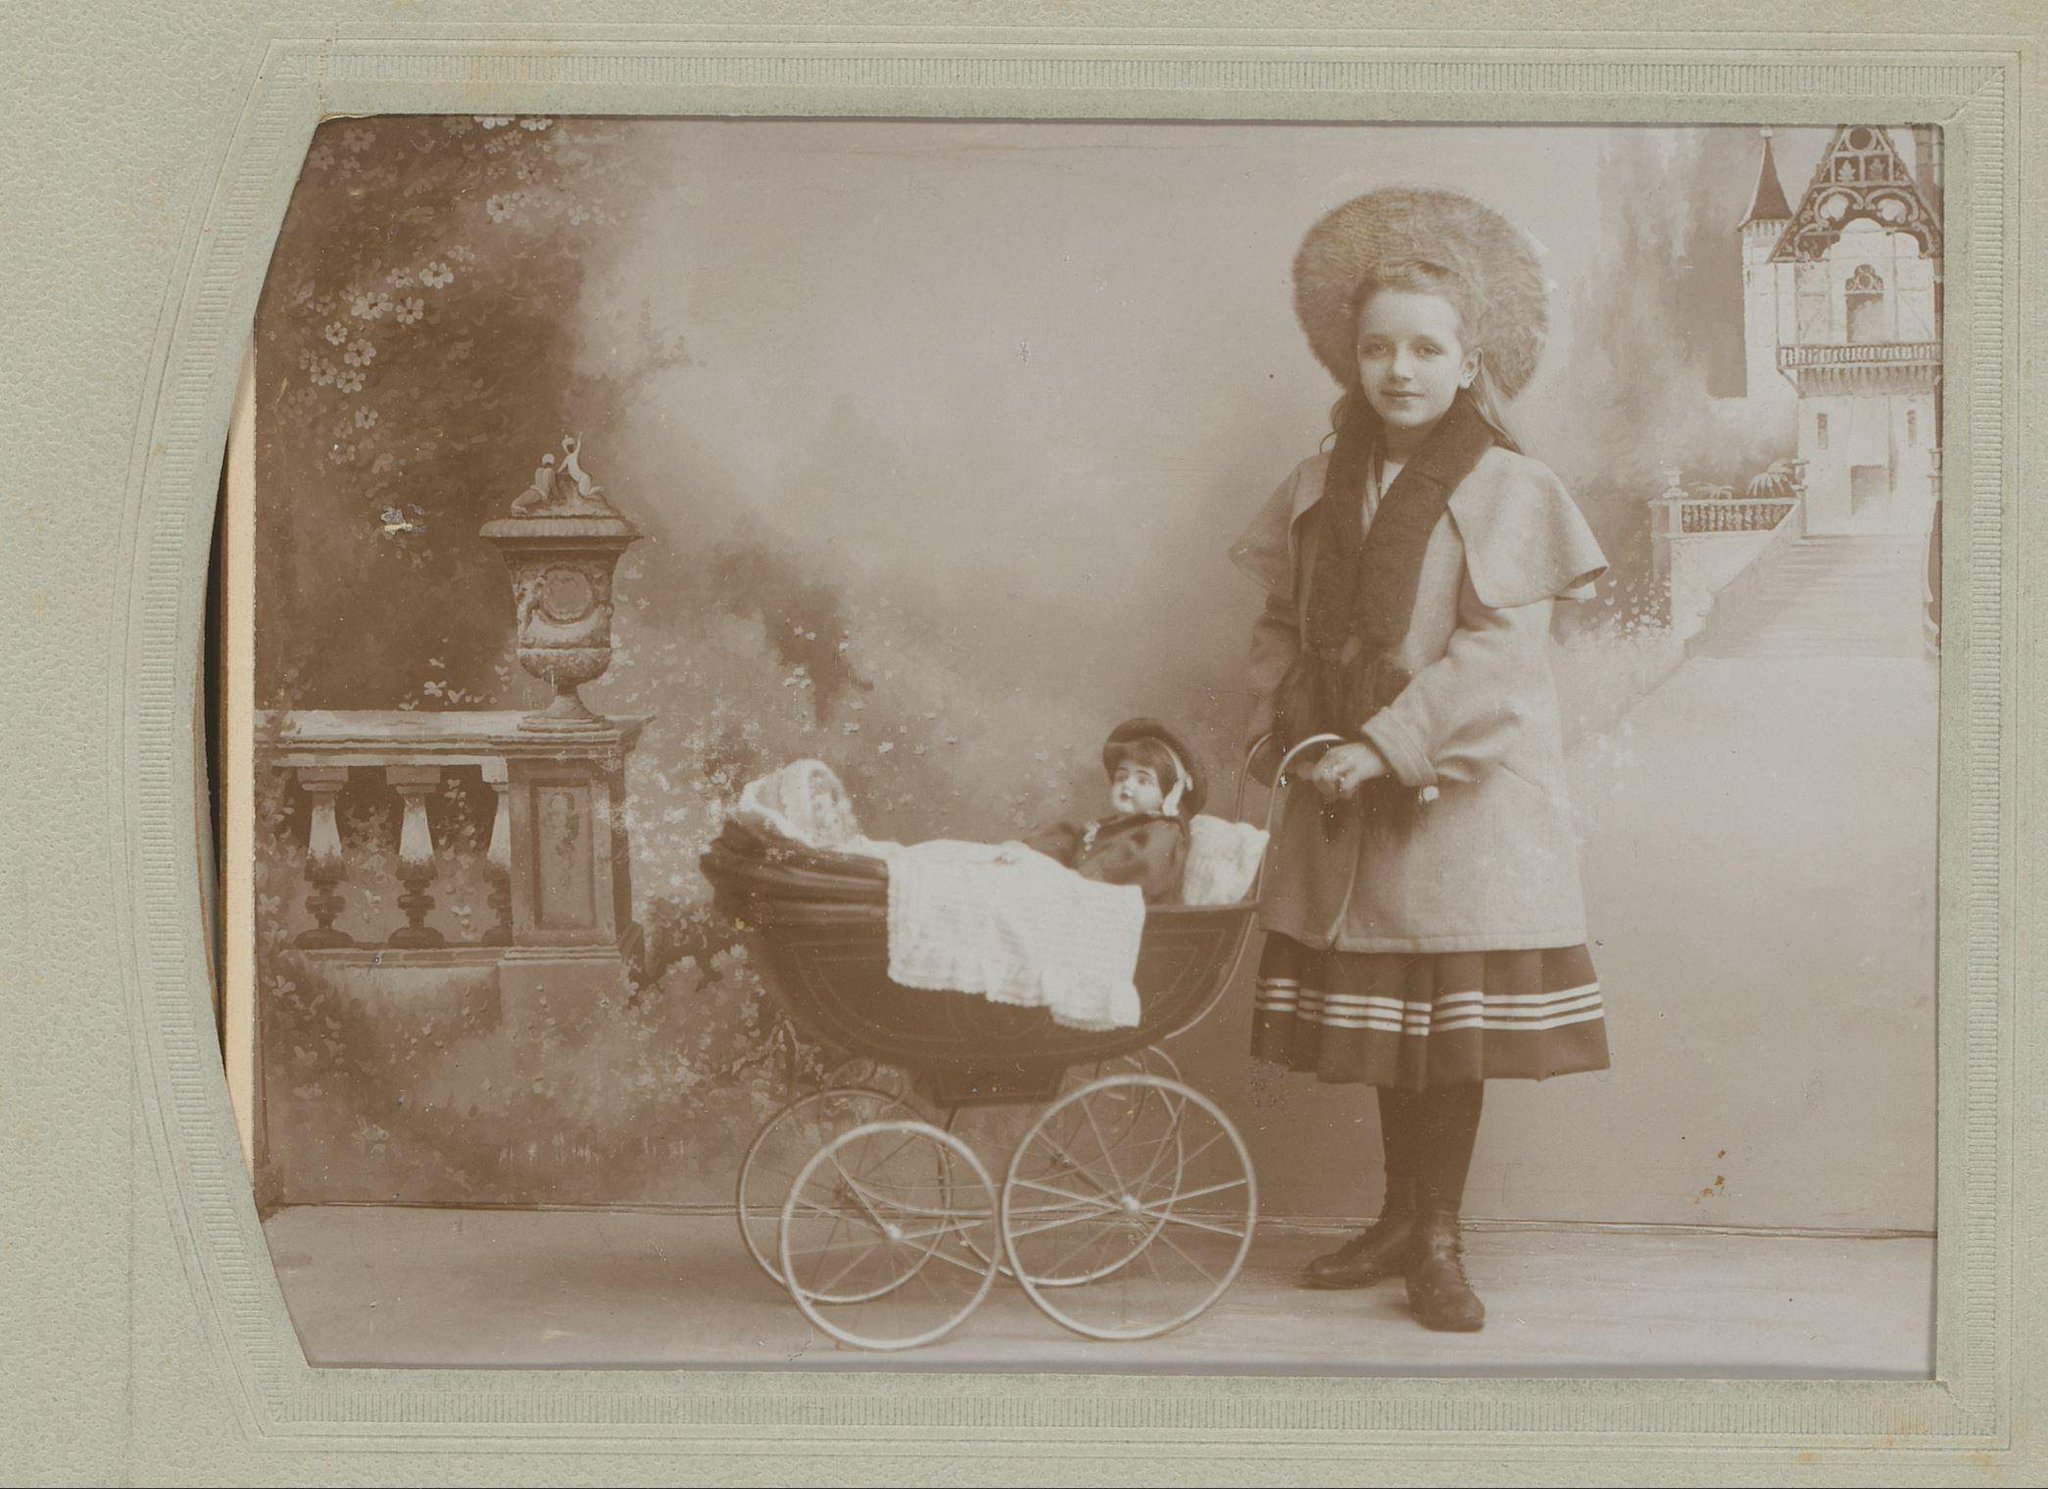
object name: album leaf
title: Portret van een onbekend meisje met een poppenwagen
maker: theodor liebert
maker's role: fotograaf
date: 1900-1915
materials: paper, cardboard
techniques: collodion silver print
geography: bremen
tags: baby-carriage, pram, perambulator, girl (child between toddler and youth), anonymous historical person portrayed, (playing with) dolls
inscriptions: number: ‘322’, inscription: ‘Th. Liebert/ Fehrfeld 61/ Ecke vor dem Steinthor./ Bremen.’